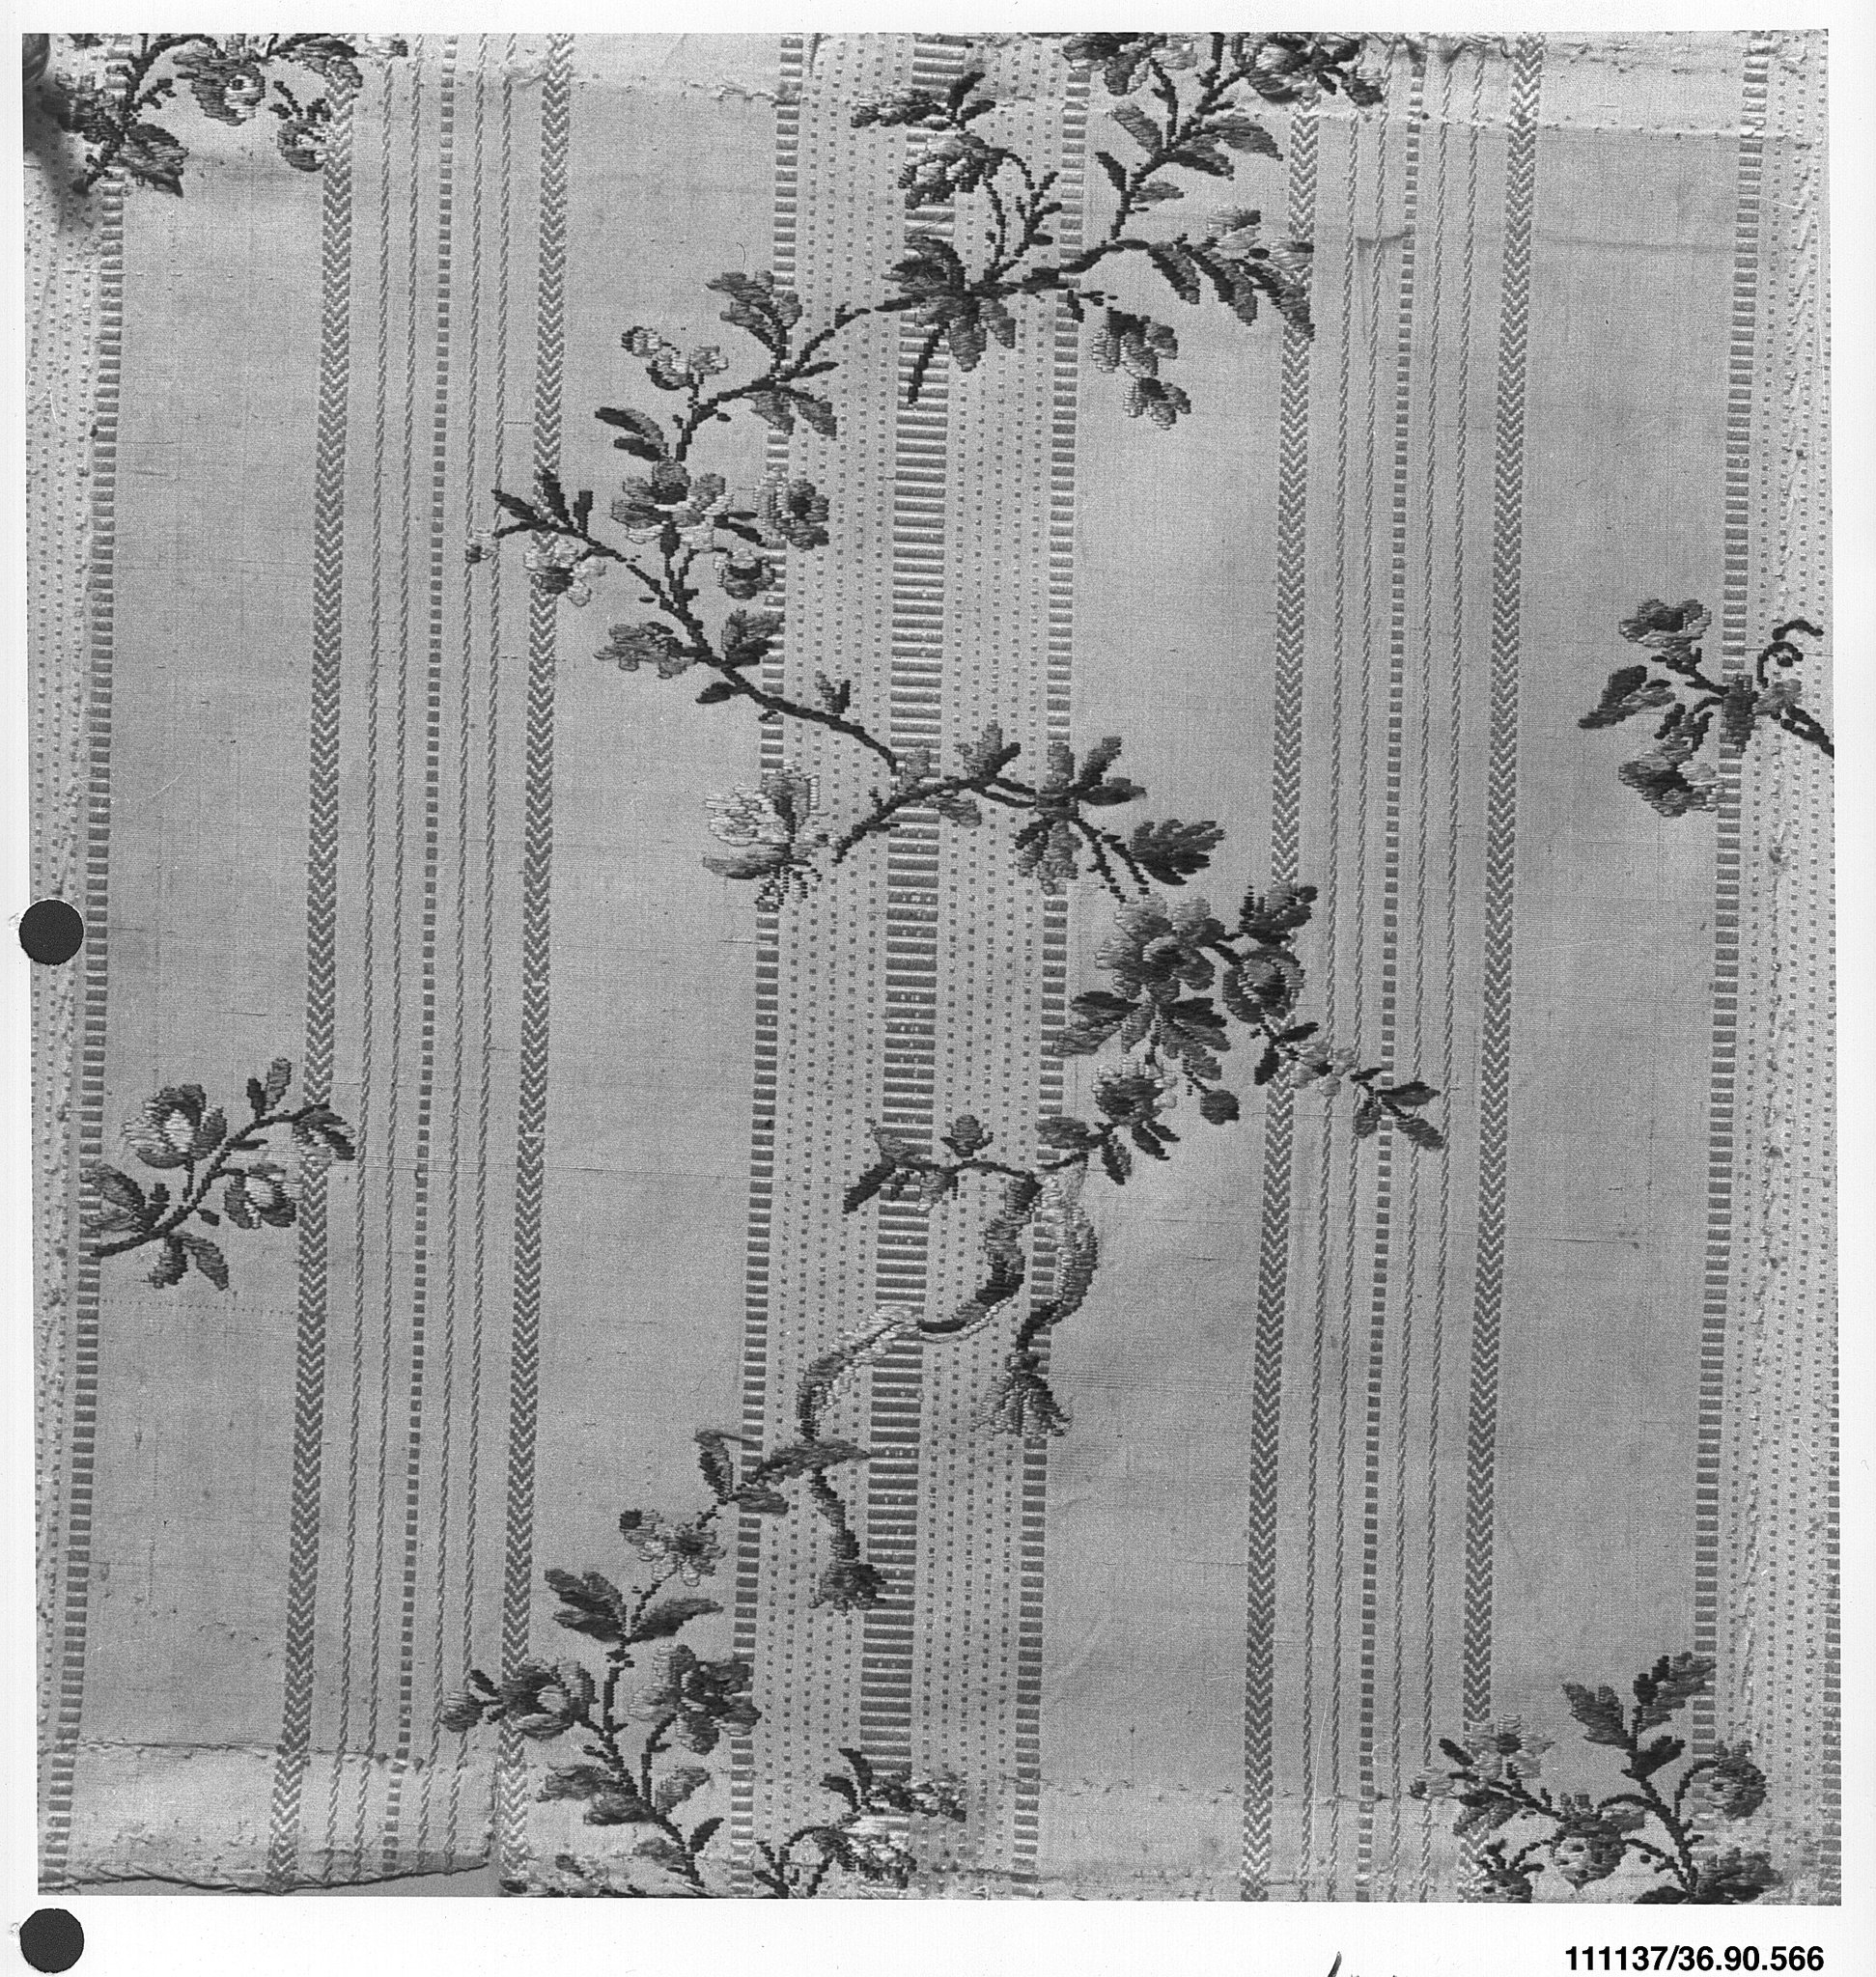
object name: piece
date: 1767-1800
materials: silk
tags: flowers,leaves